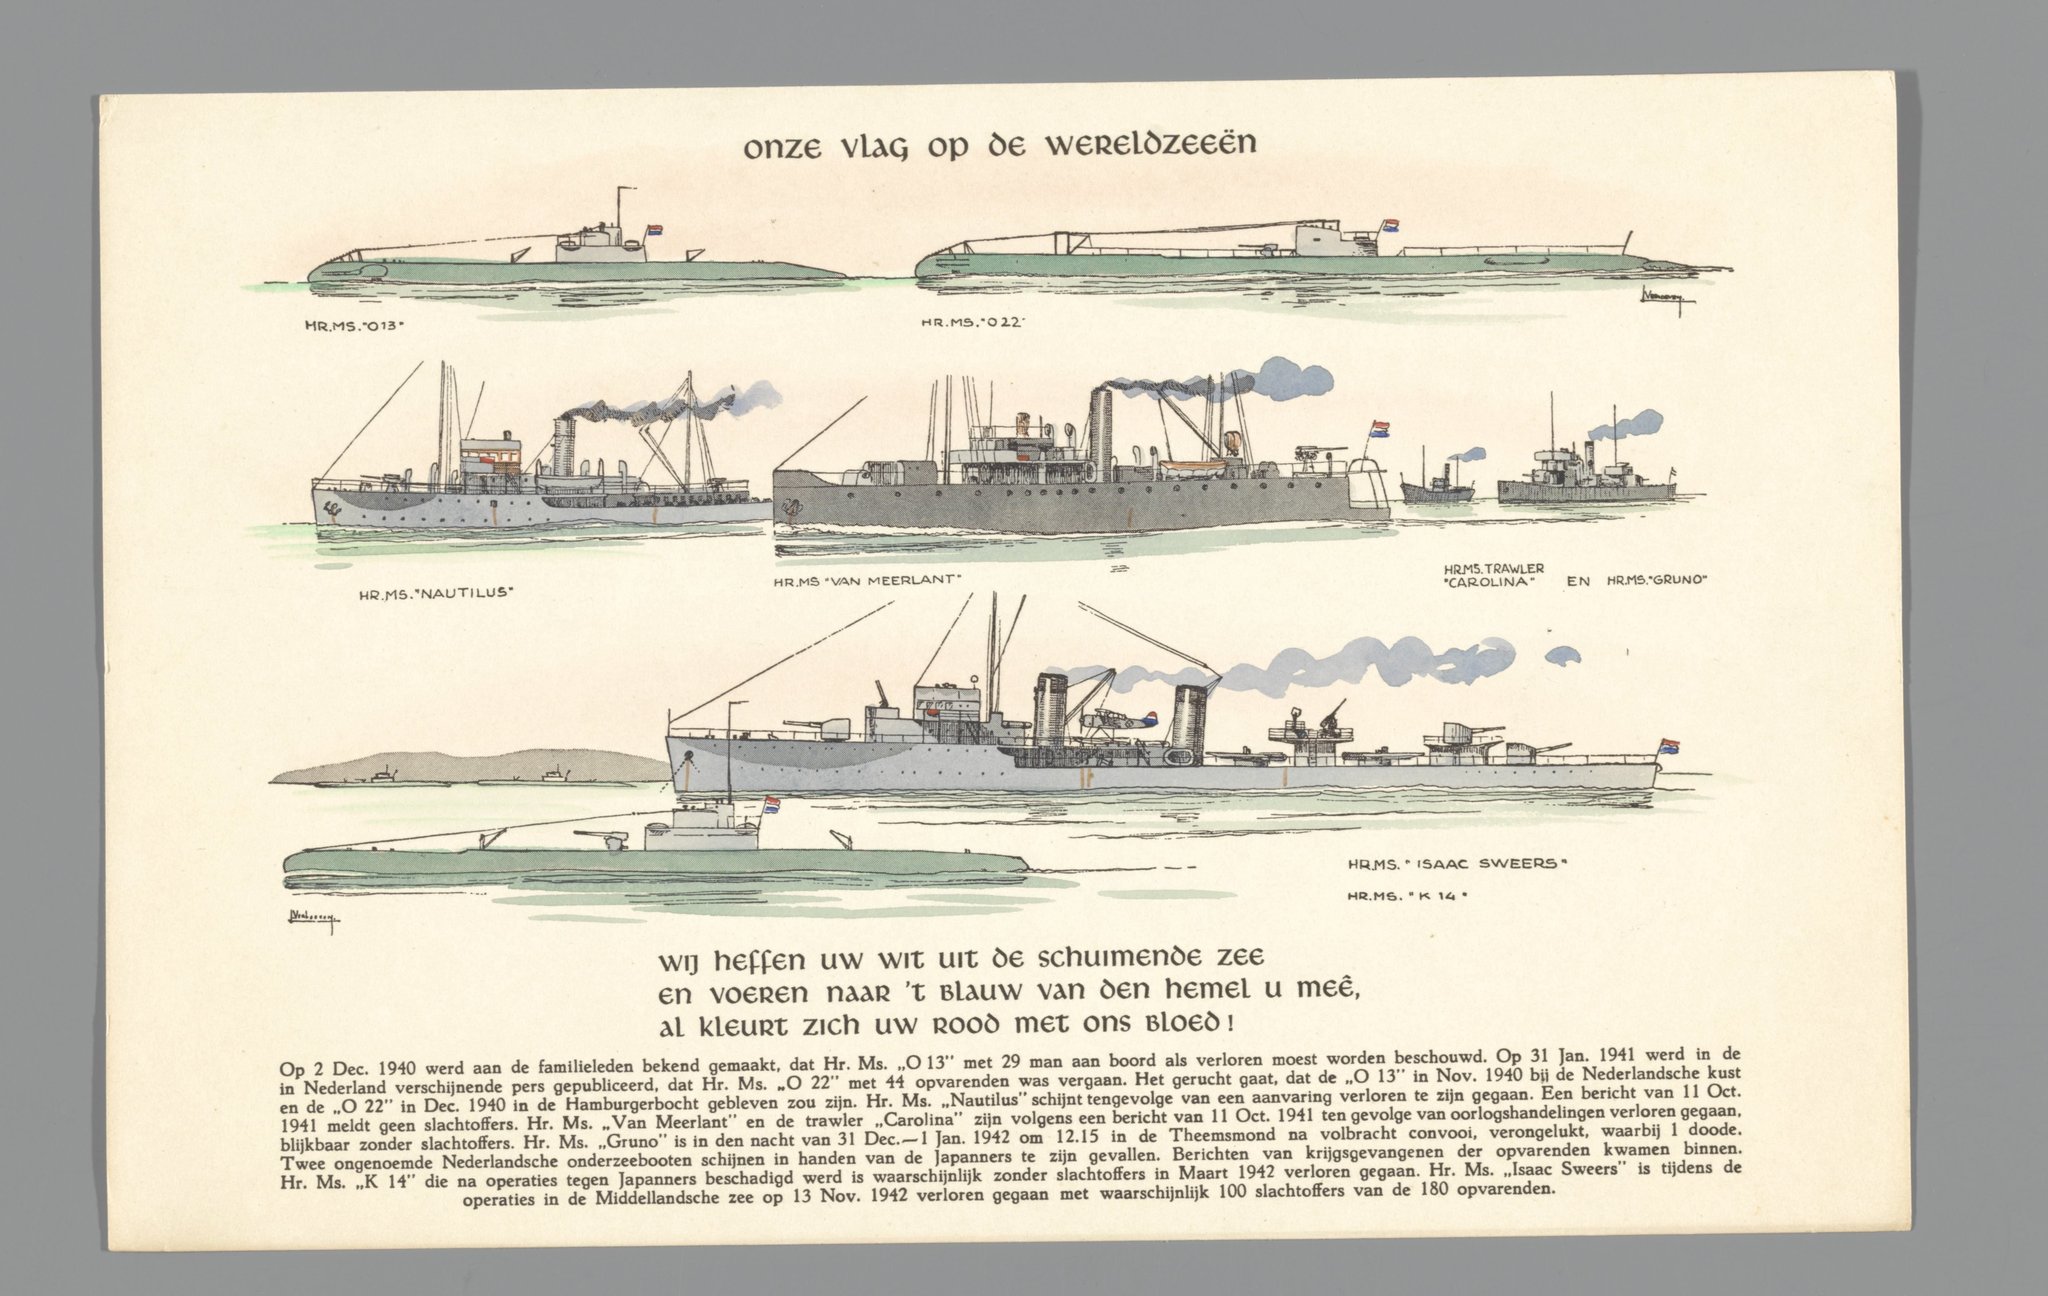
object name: print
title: Nederlandse oorlogsschepen die vergaan zijn in 1940-1942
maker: j. verhoeven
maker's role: draughtsman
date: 1945-1960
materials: paper, watercolor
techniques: hand coloring, printing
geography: netherlands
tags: tweede wereldoorlog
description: Blad met acht Nederlandse oorlogsschepen die vergaan zijn in de jaren 1940-1942, onder andere in de strijd tegen Japan. Acht marineschepen zijn afgebeeld: Hr.Ms. O13, Hr.Ms. O22, Hr.Ms. Nautilus, Hr.Ms. Van Meerlant, Hr.Ms. Trawler Carolina, Hr.Ms. Gruno, Hr.Ms. Isaac Sweers en Hr.Ms. K14. Onder de afgebeelde schepen een drieregelig vers en een tekst waarin staat wanneer en hoe het schip vergaan is. Drie van de afgebeelde schepen zijn onderzeeboten. Onderdeel van een groep van drie platen.